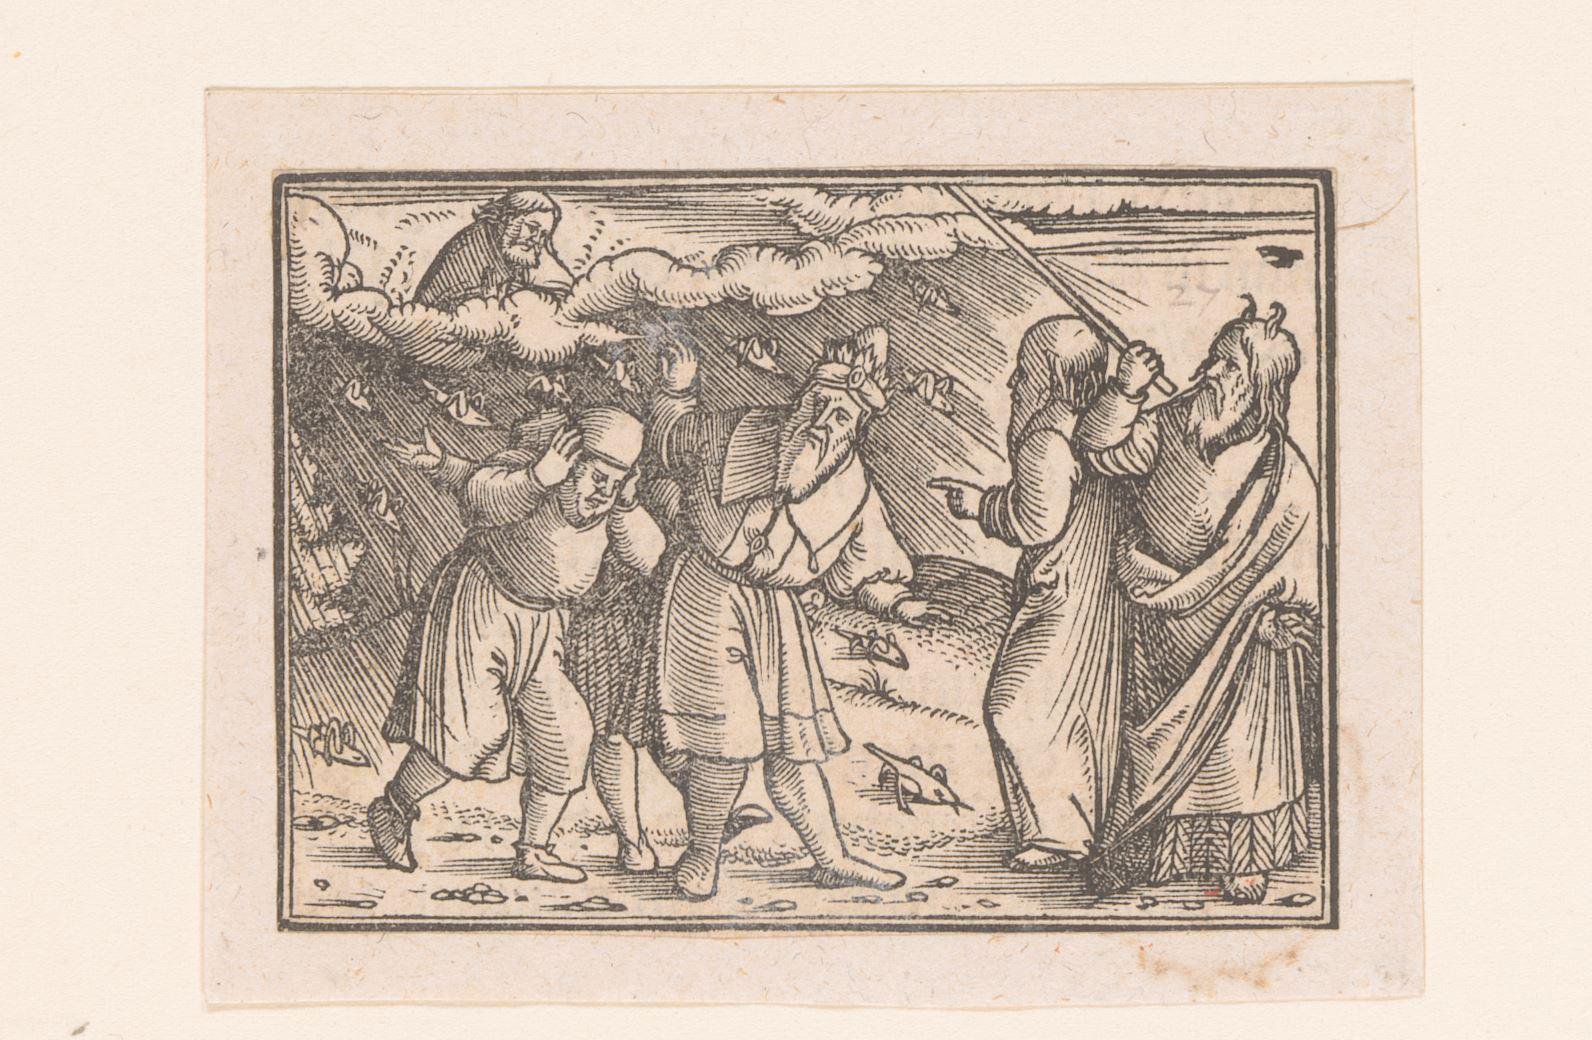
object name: book illustration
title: Achtste plaag: sprinkhanen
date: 1522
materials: paper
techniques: woodcut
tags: the plague of locusts: as moses raises his hands the locusts come and eat everything that has survived the hail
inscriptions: collector's mark: Lugt 240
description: Mogelijk een kopie van een prent van Hans Holbein de jongere. Niet uit de Icones historiarum Veteris Testamenti van 1538. Deze kopie mogelijk uit: Biblia sacra iuxta vulgatam. Parijs: Jean Benoît, 1552. Ook aanwezig in de Herzog August Bibliothek: http://diglib.hab.de?grafik=graph-res-d-326-1.